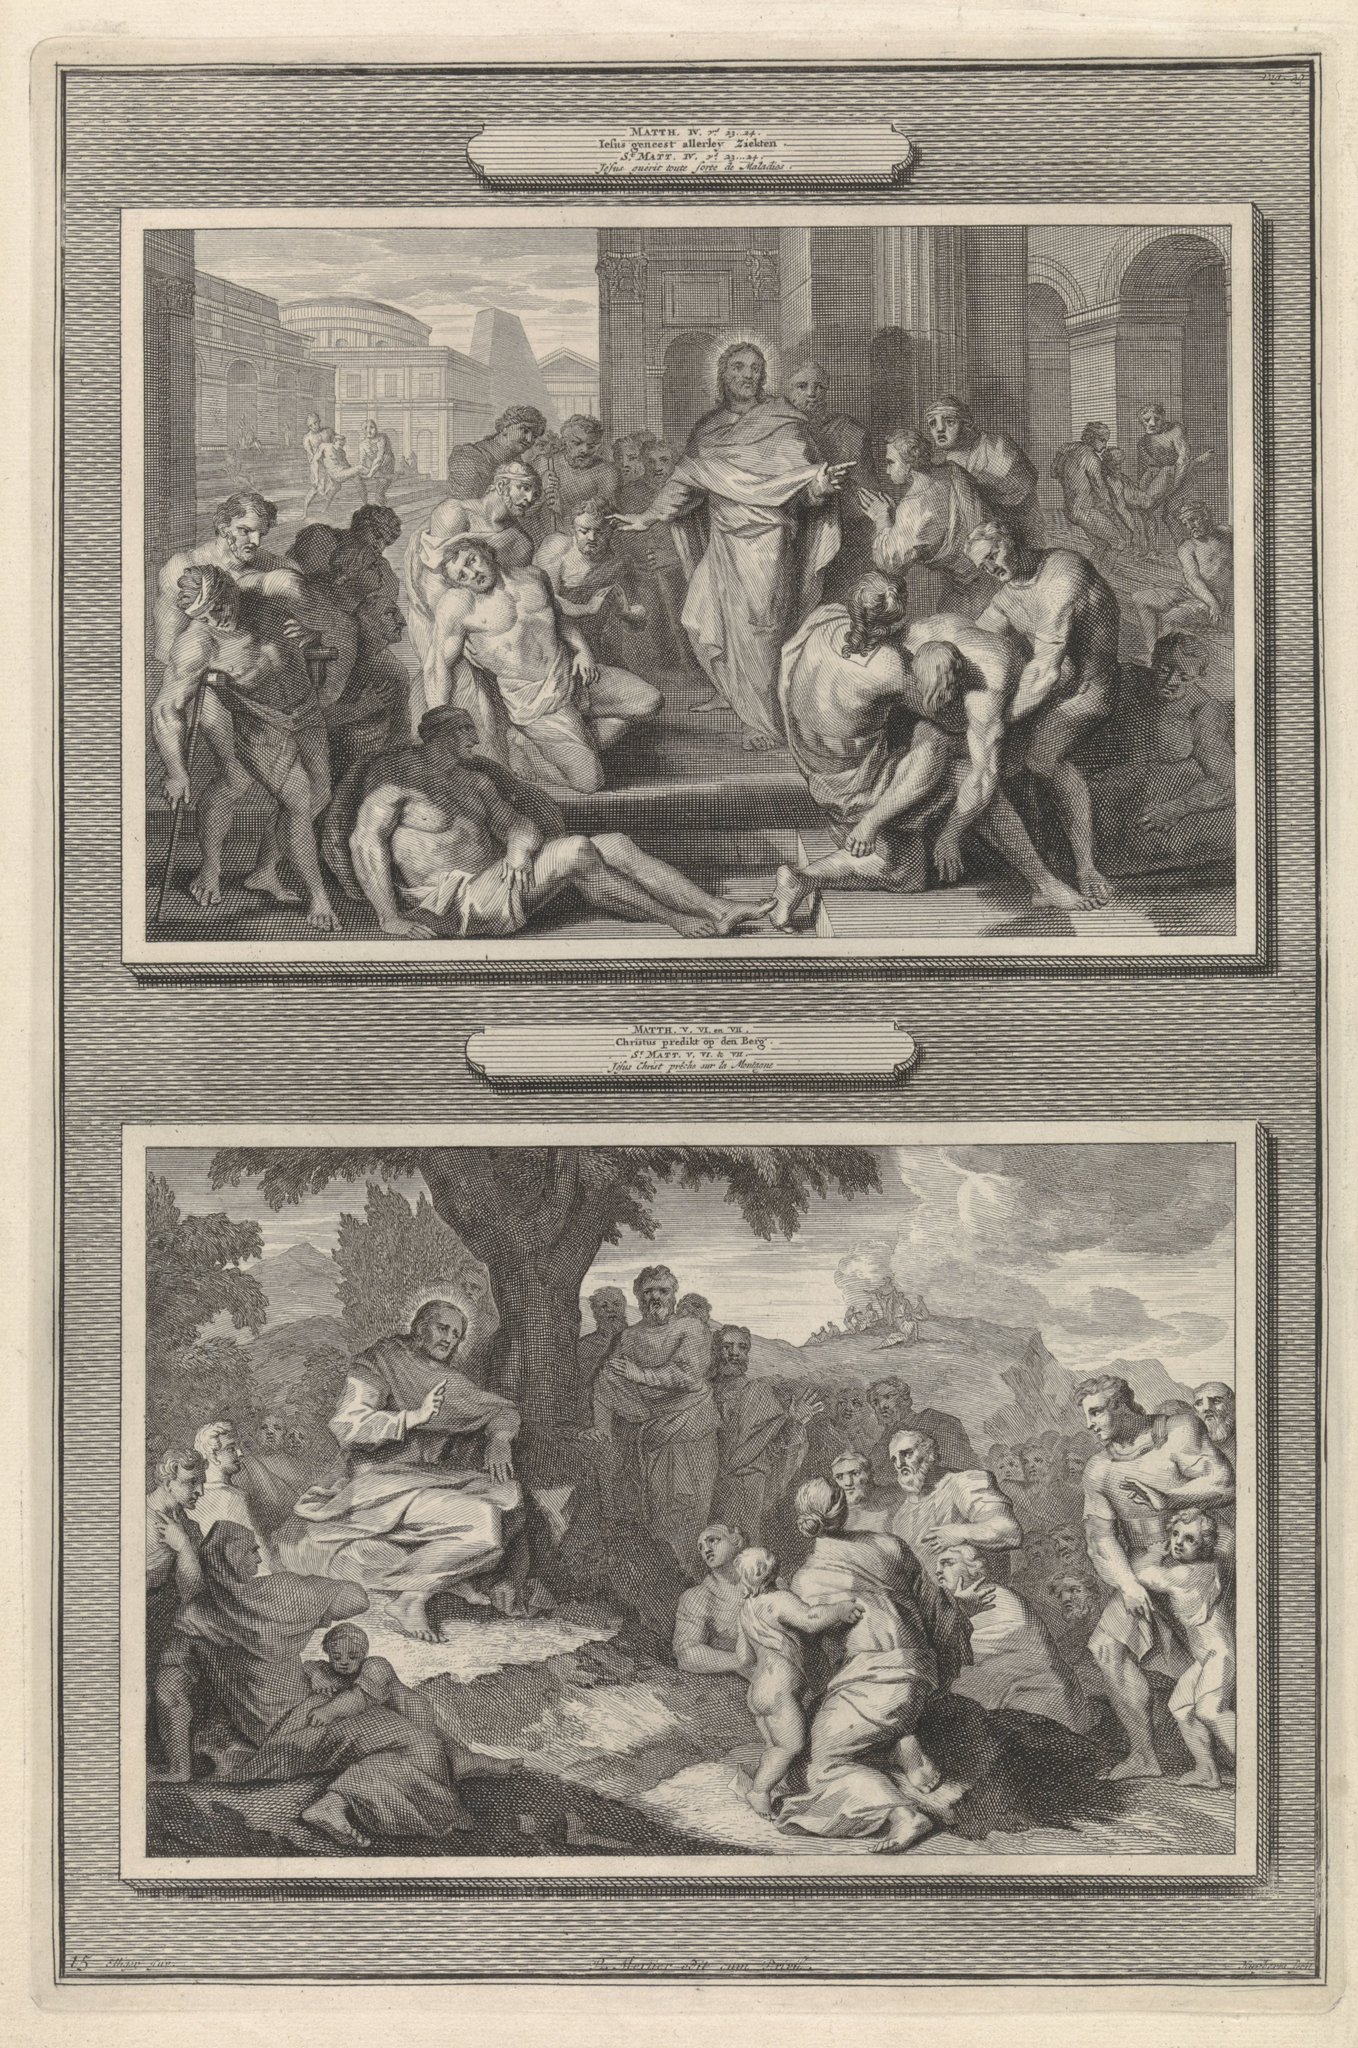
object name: book illustration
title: Christus geneest de zieken / de Bergrede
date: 1700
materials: paper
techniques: engraving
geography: amsterdam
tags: christ's sermon on the mount (matthew 5-7), miracles of christ ~ healing the sick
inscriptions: collector's mark: Lugt 2228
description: Twee voorstellingen op een plaat bij het evangelie van Mattheüs. Op de bovenste voorstelling staat Christus te midden van de zieken, die naar hem worden gebracht. Boven de voorstelling de verwijzing naar Mat. 4:23-24 in het Nederlands en het Frans. Op de onderste voorstelling de bergrede. Christus zit links onder een boom waar hij predikt tot zijn toehoorders. Boven de voorstelling de verwijzing naar Mat. 5, 6 en 7 in het Nederlands en het Frans. Linksonder gemerkt: 15.